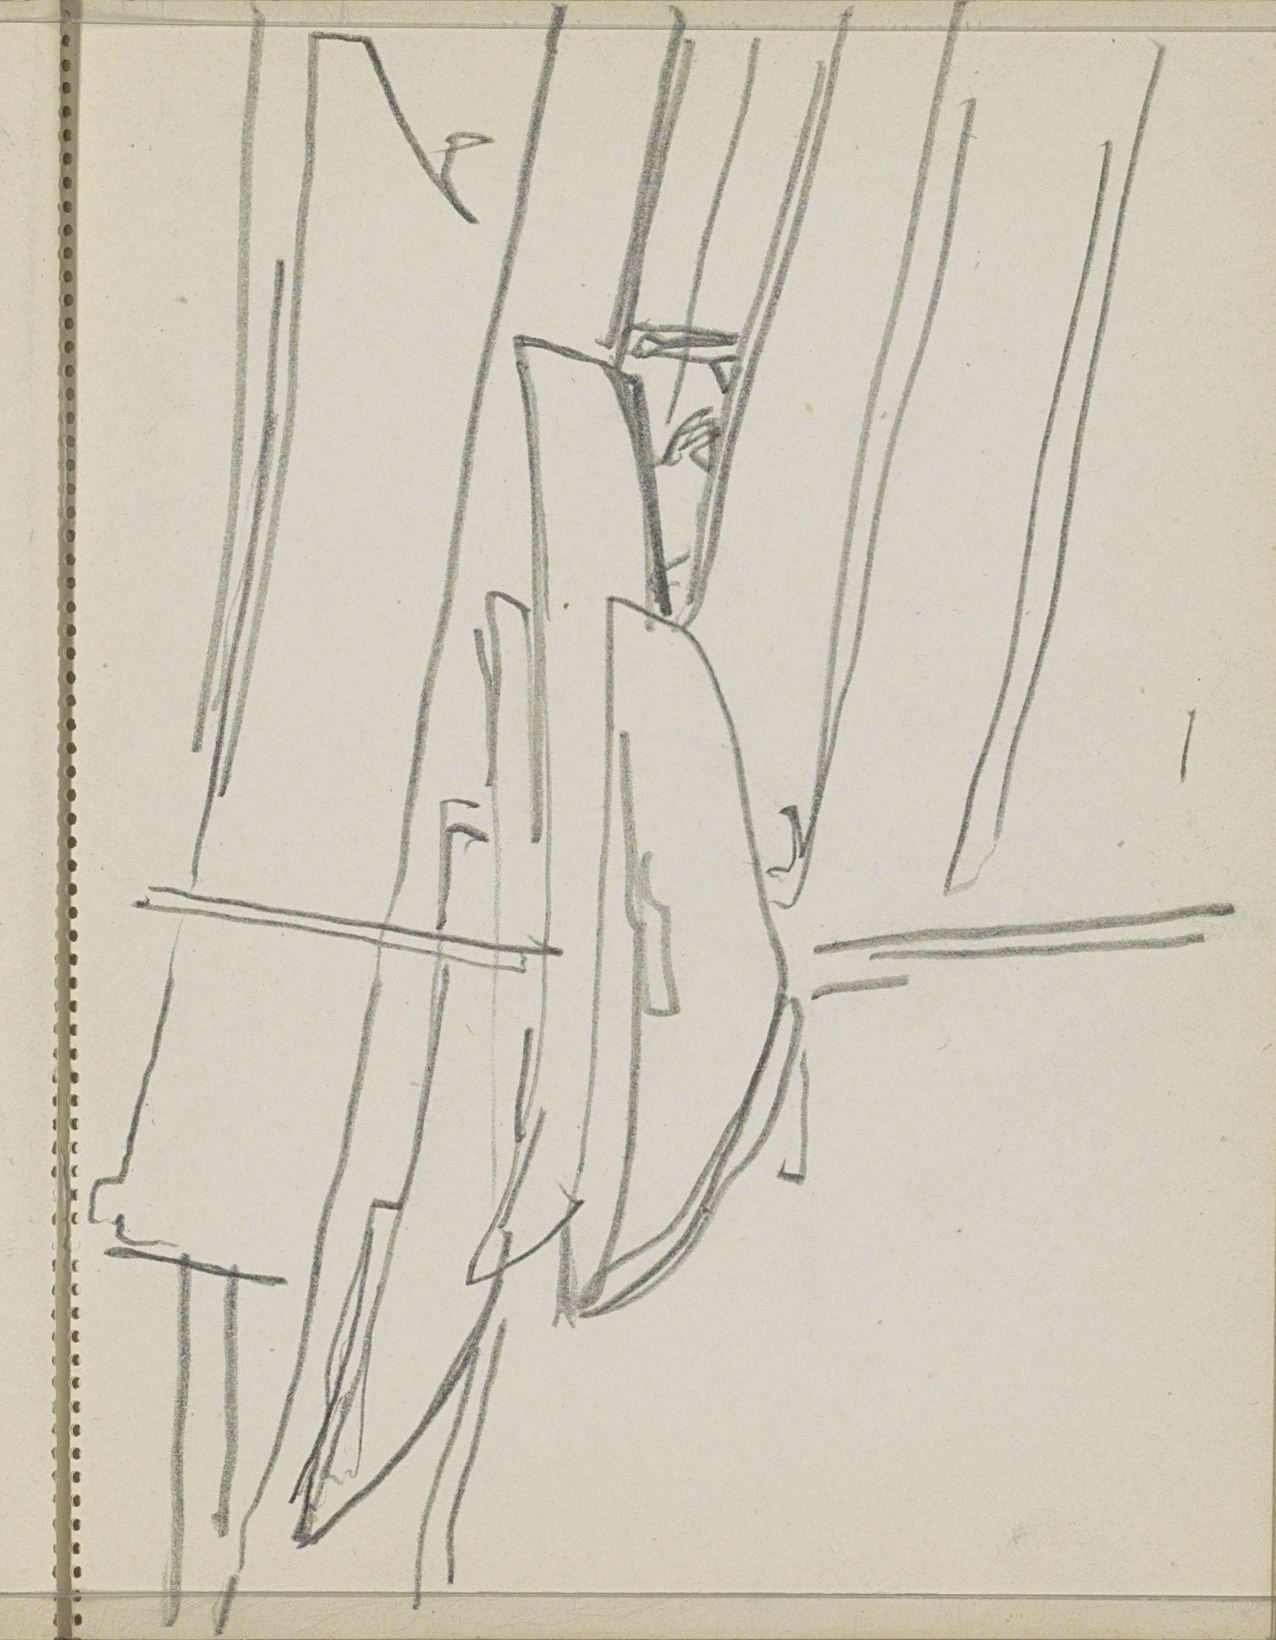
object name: sketchbook leaf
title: Zeilboten op een werfhelling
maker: reijer stolk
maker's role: draughtsman, print maker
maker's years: 1896-1945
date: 1906-1945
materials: paper, pencil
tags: sailing-ship, sailing-boat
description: Blad 14 recto uit een schetsboek met 53 bladen.